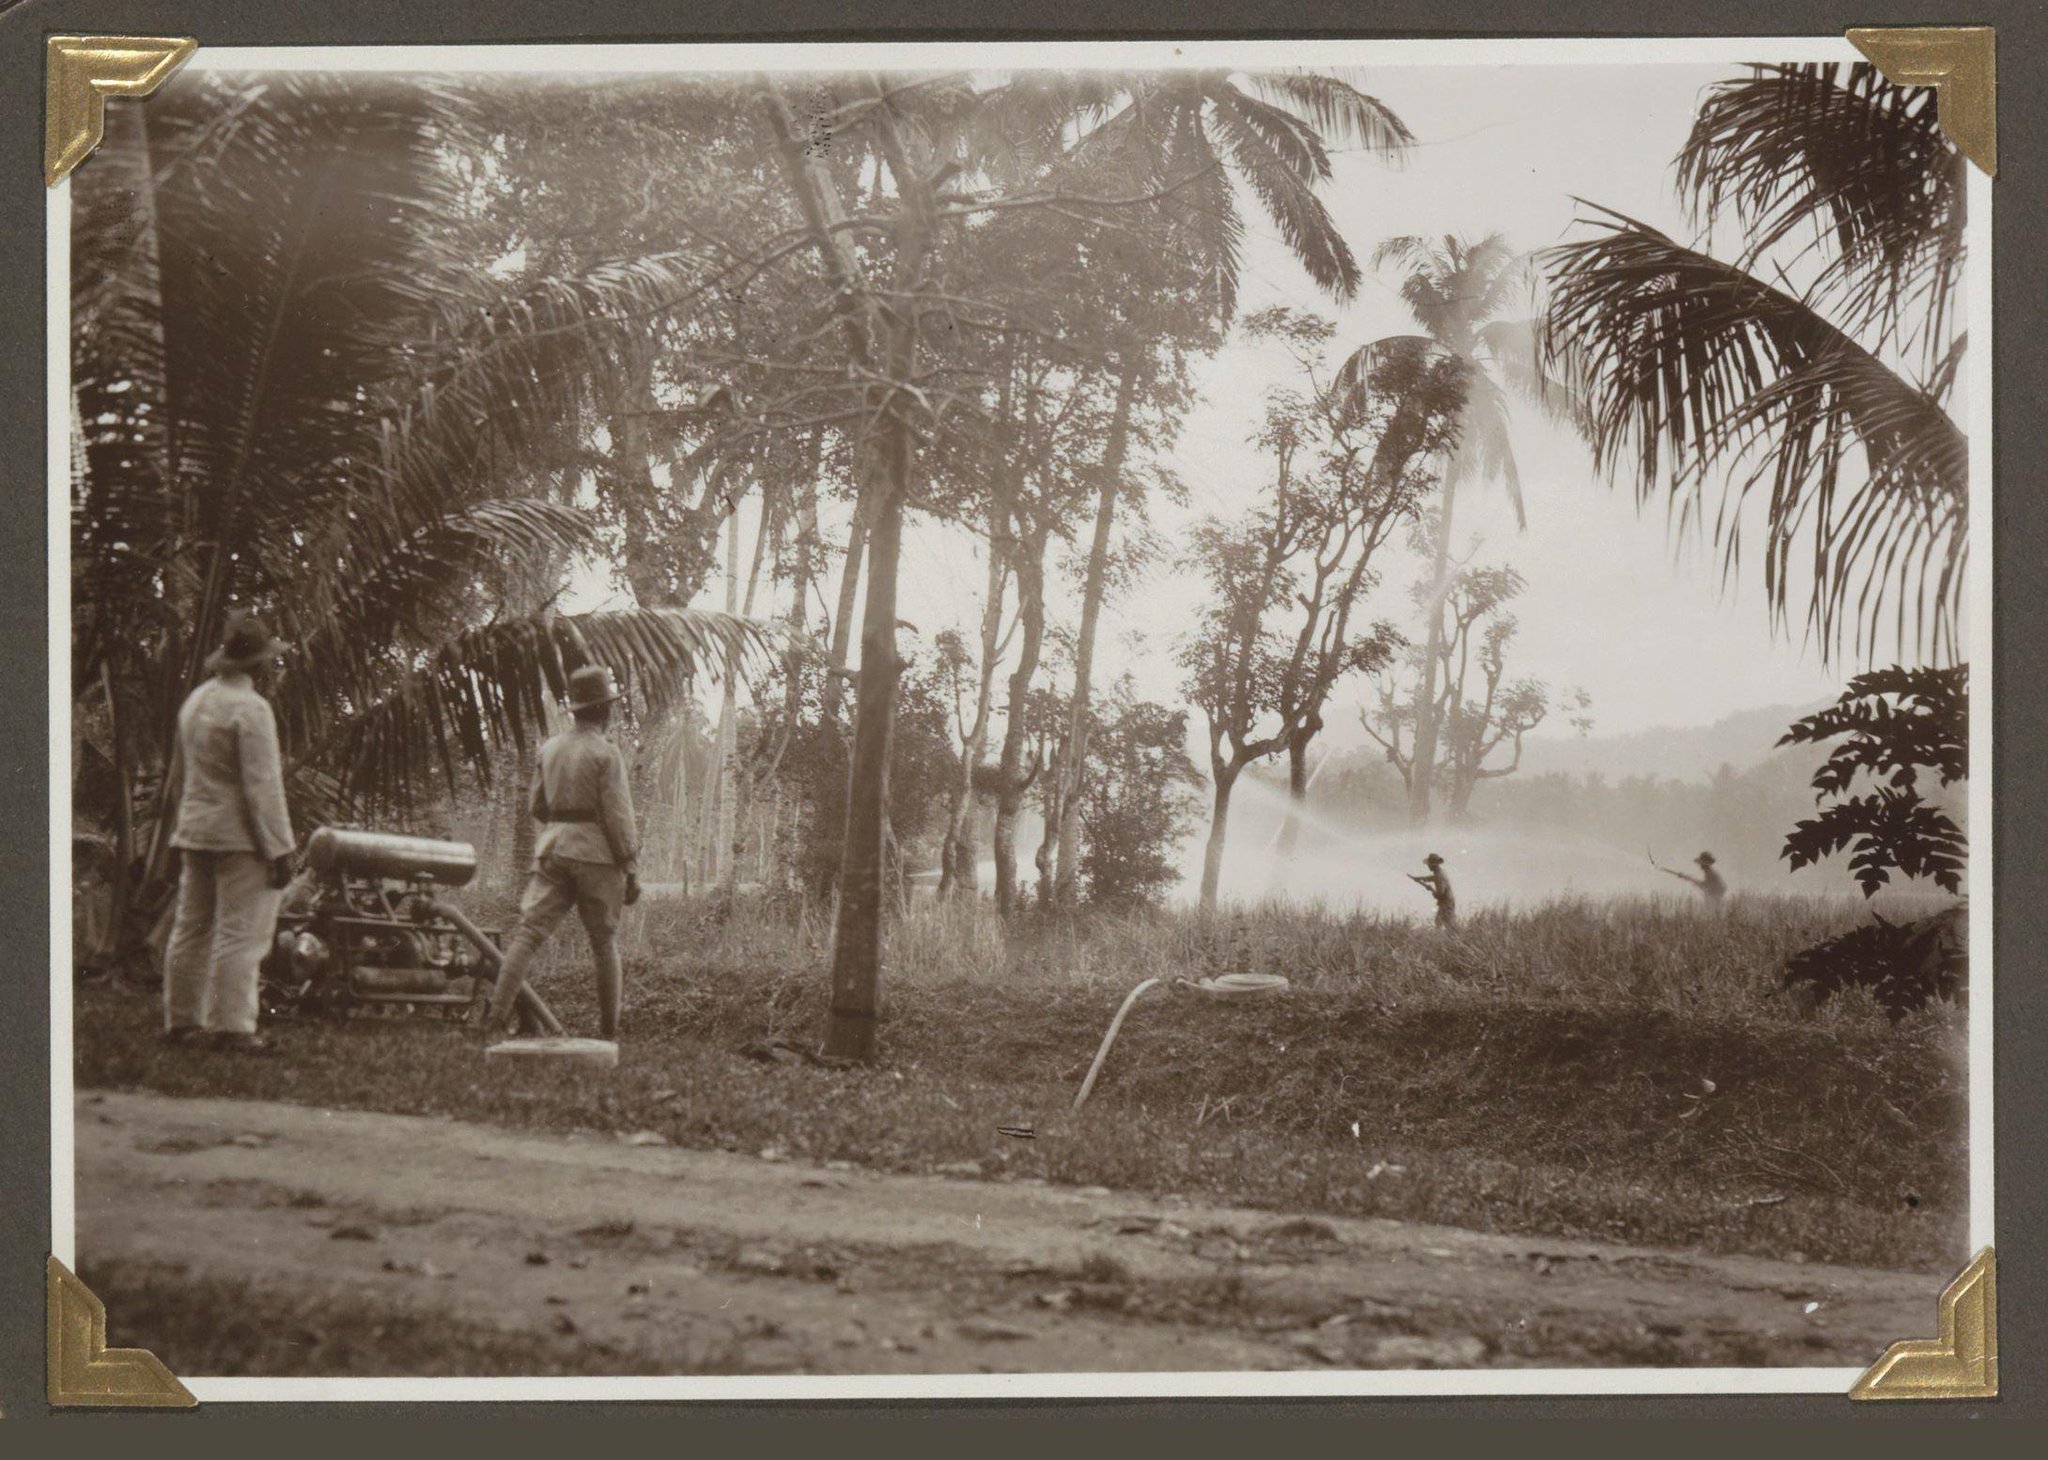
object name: photograph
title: Politiebrandweerlieden van Tandjongkarang blussen brandend grasveld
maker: Anonymous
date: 1932-1933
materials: photographic support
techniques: gelatin silver print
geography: lampung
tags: fire-fighting, firemen, police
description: Onderdeel van Herinneringsalbum voor F.J. Junius, vertrekkend resident van Lampong (Zuid-Sumatra).